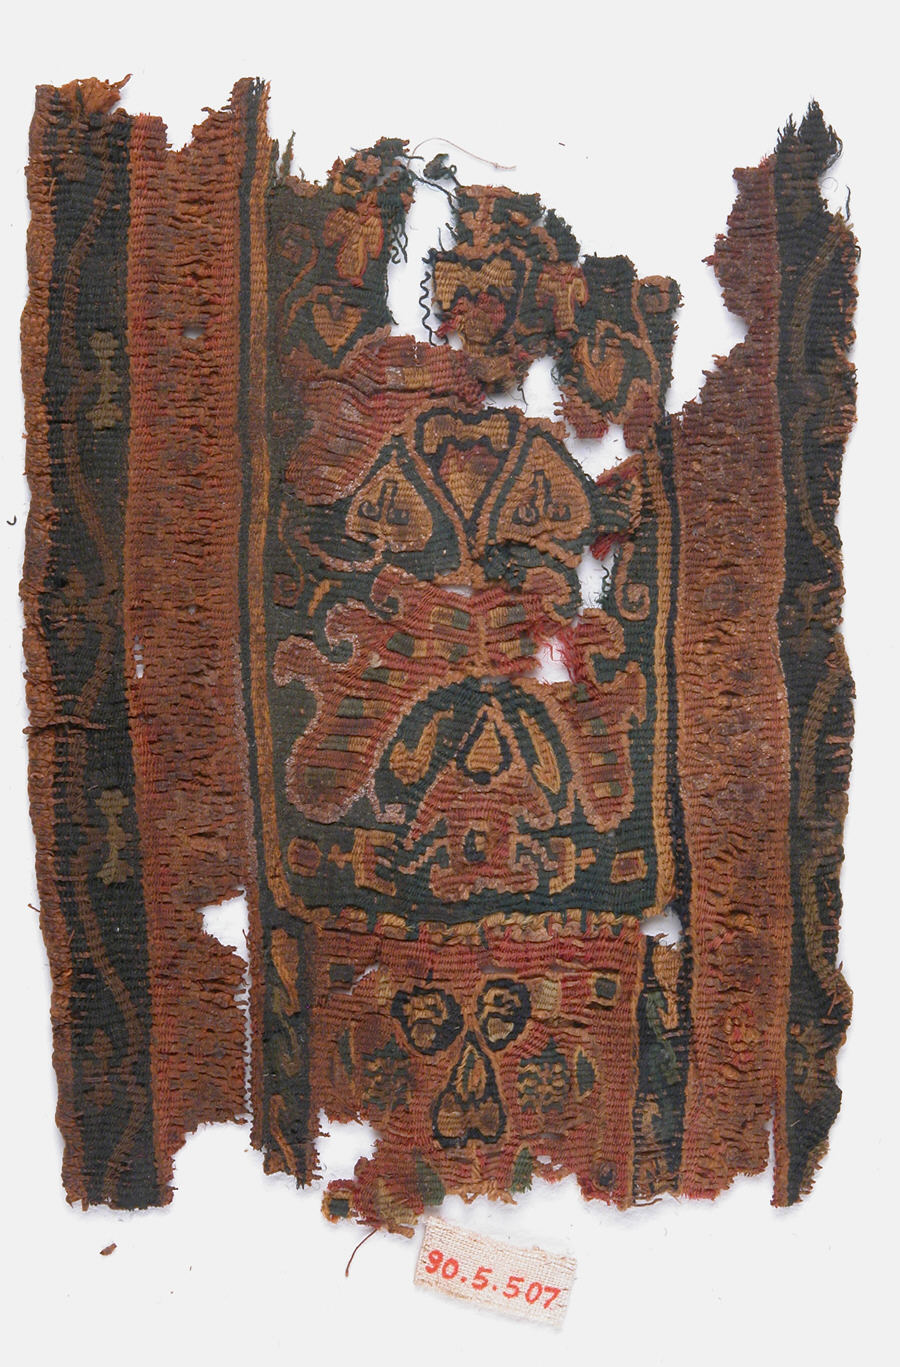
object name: textile fragment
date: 501-800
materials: linen, wool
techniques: weave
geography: egypt